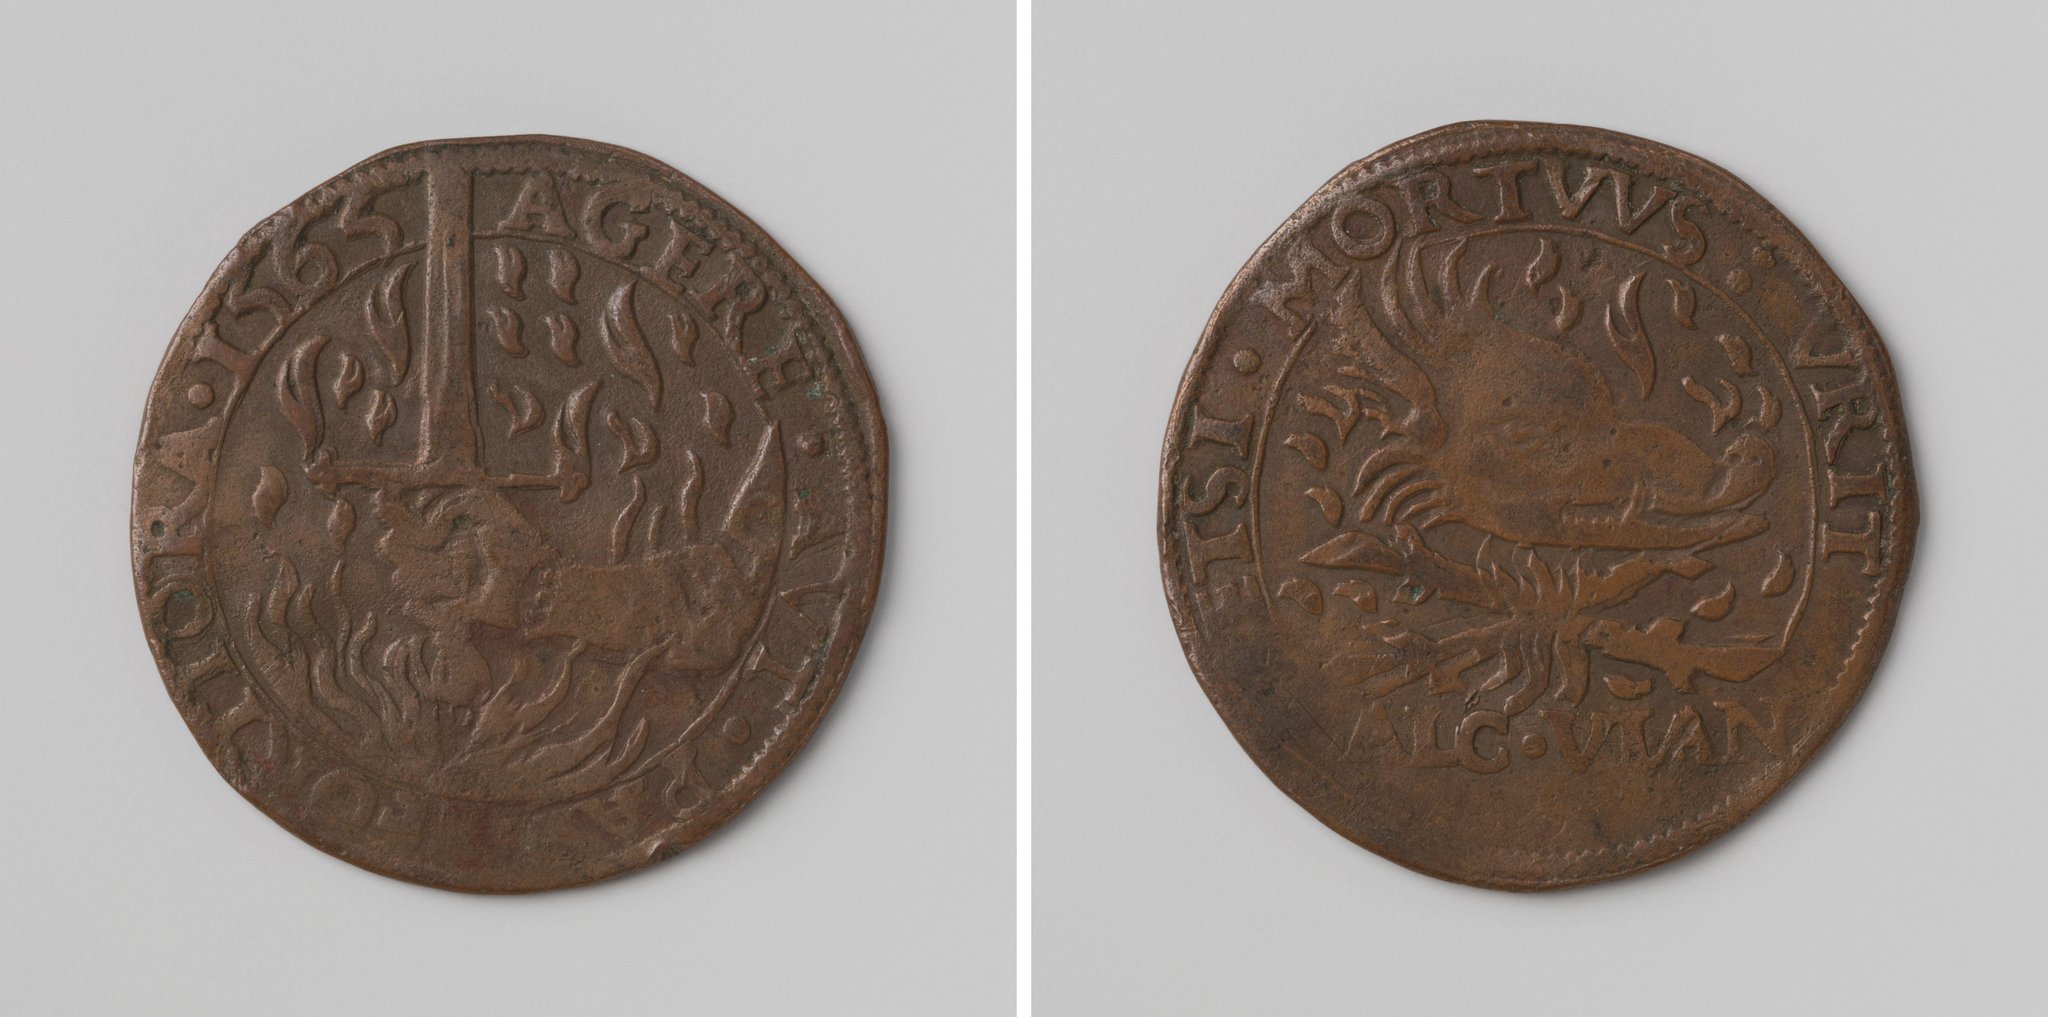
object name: jeton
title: Verzet tegen het besluit van Filips II, koning van Spanje om de plakaten en de inquisitie te handhaven, rekenpenning van Vianen, ter ere van Hendrik van Brederode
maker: Anonymous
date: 1565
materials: copper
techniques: striking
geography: netherlands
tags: hendrik van brederode (heer van vianen), vianen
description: Koperen penning. Voorzijde: arm, die zwaard in vlammen houdt binnen omschrift. Keerzijde: kop van everzwijn boven brandend Bourgondisch kruis, omringd door vlammen binnen omschrift